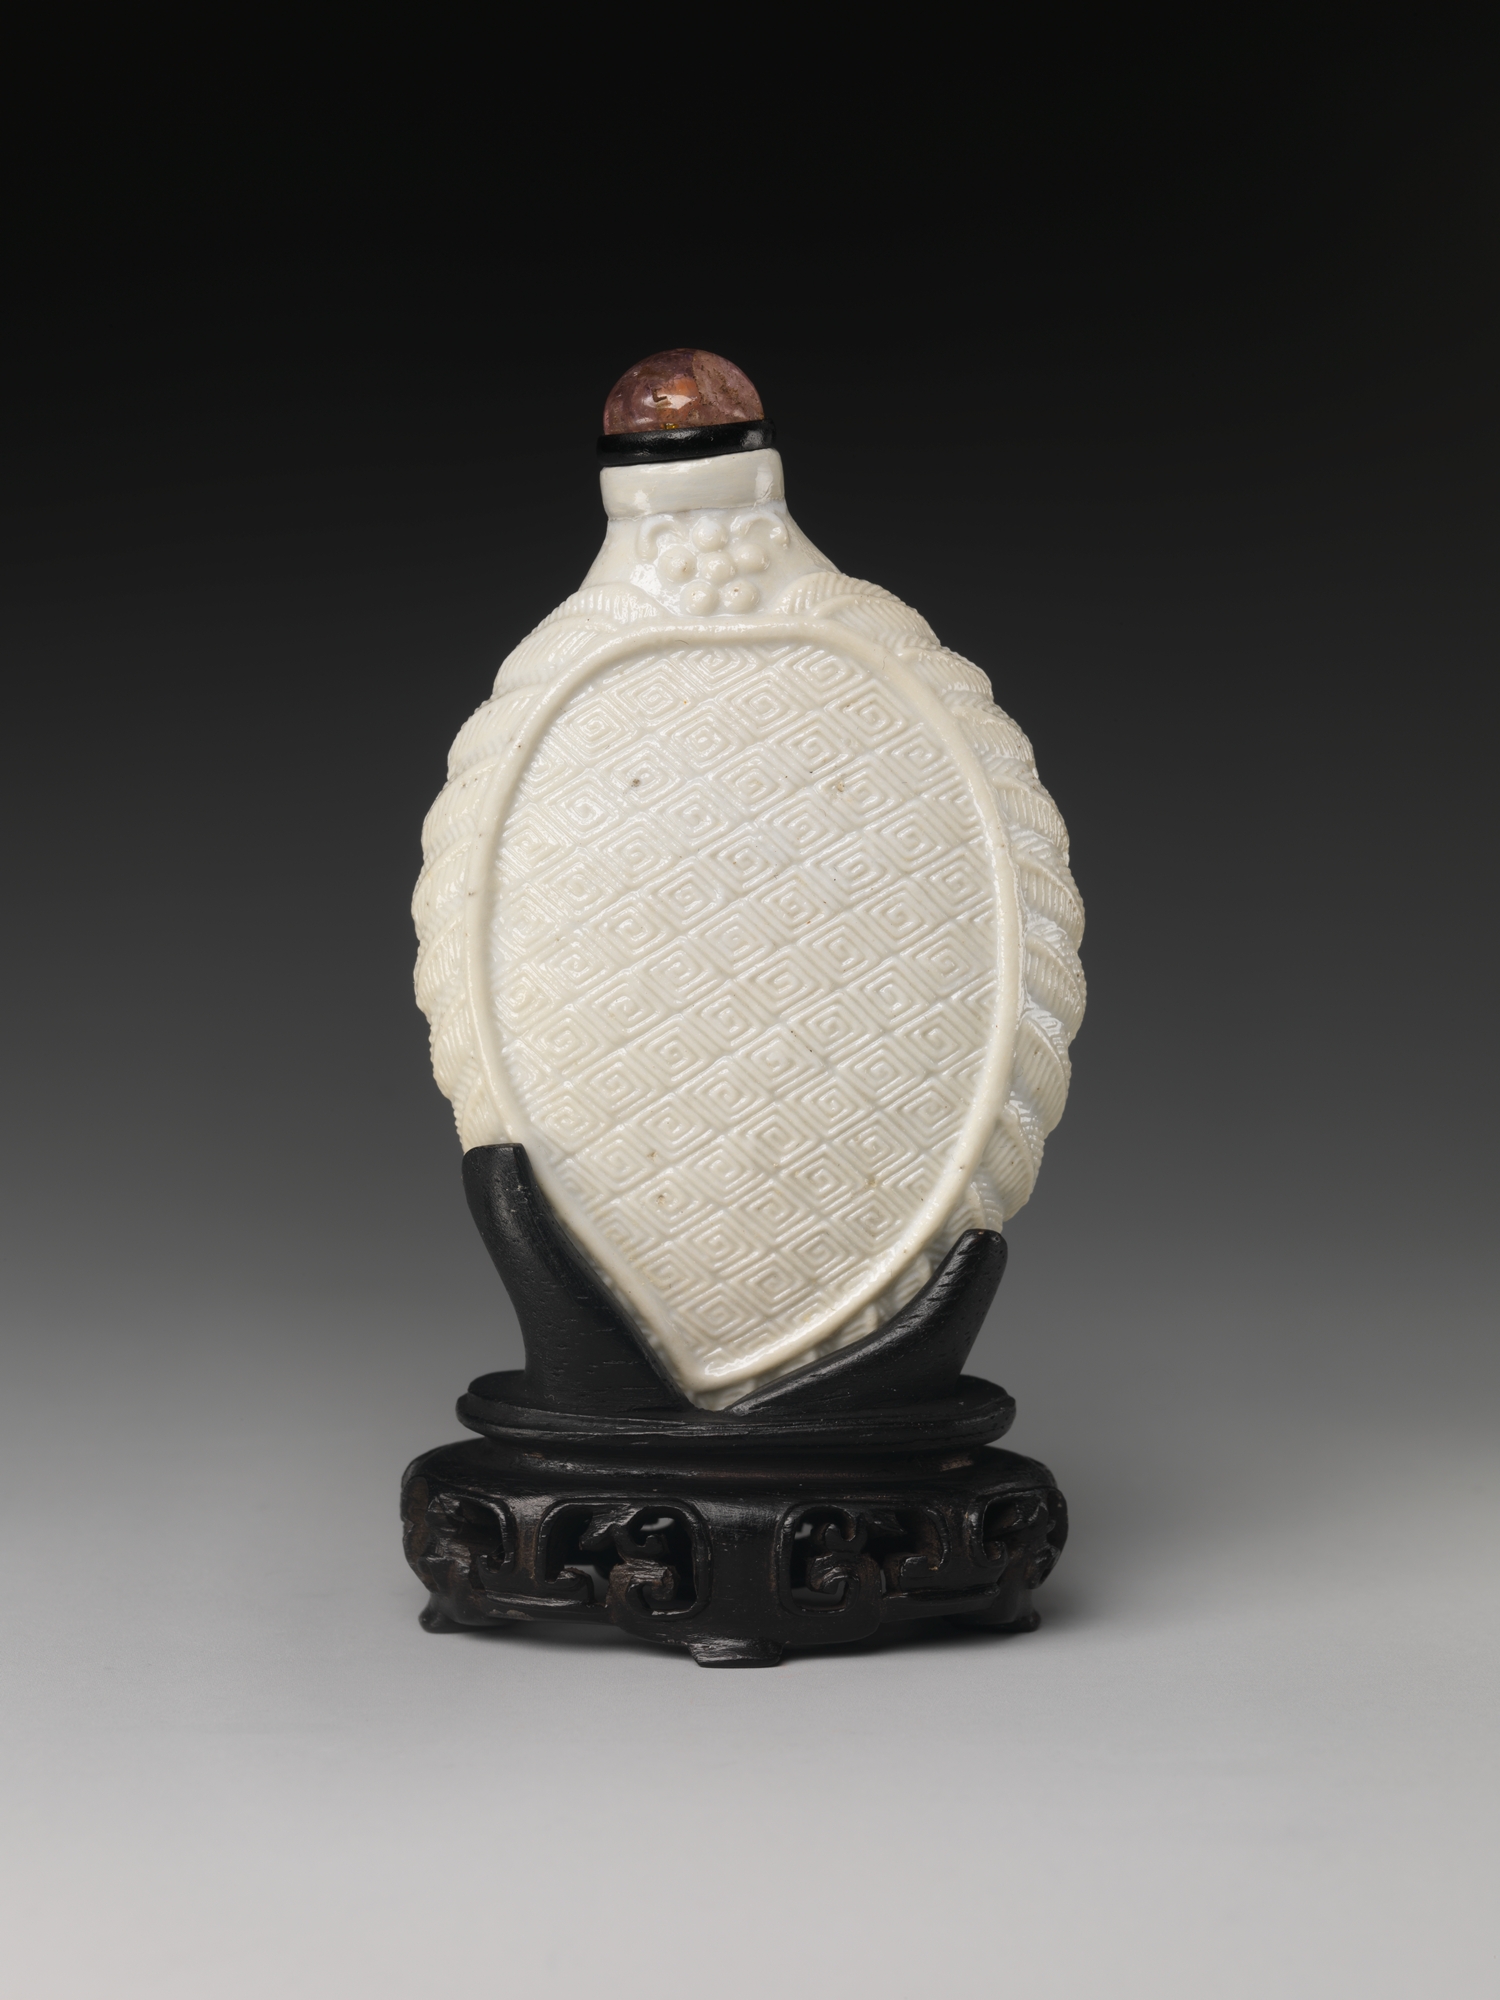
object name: snuff bottle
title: Snuff Bottle in the Shape of a Leaf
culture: chinese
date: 1801-1833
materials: porcelain, gemstone